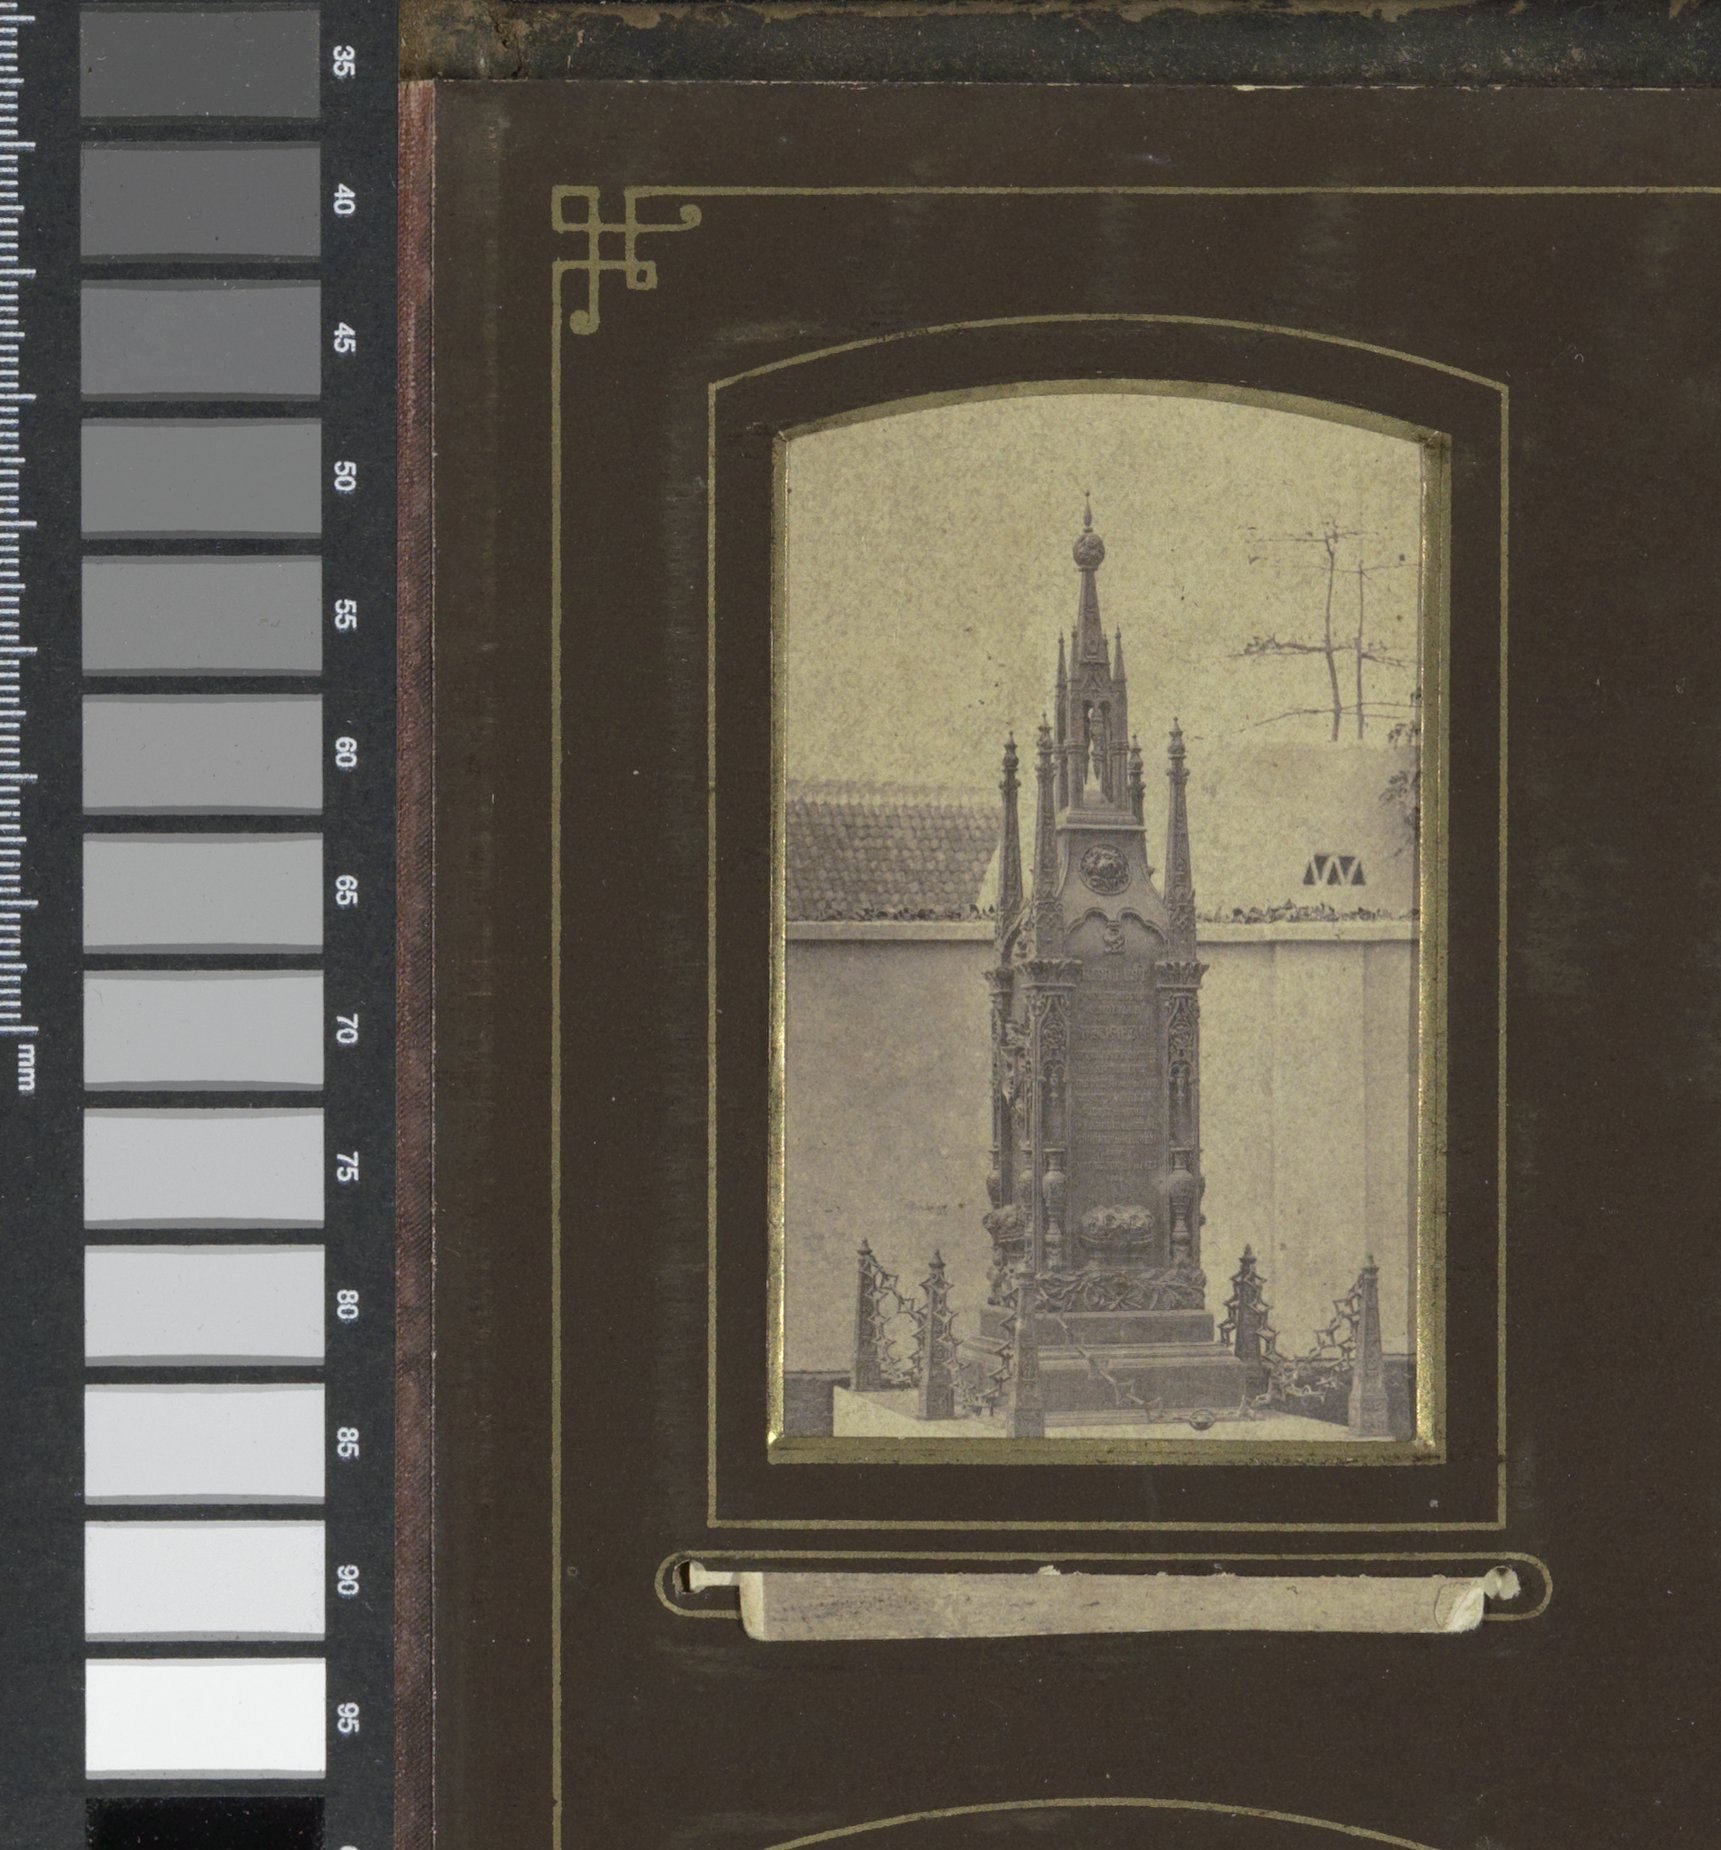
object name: photograph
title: Monument, vermoedelijk ter nagedachtenis van een omgekomen militair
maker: Anonymous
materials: paper, photographic support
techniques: albumen print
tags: monument, statue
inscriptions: inscription: ‘[...]ier rust Paul, François, Corneil[...] [...]reede Luit Kol der art Diveet [onz] va[...] [...]e art. Con[...] winkel. Ridder der[...] [...]de van Karel II[...] [...]an Spanje geboren den 16 mei 18[...] [...]verleden den 18 Mei 1861. Achterzijde Hulde van de officieren en va[...] beambten van den A.E.[...] aan nagedachtenis van hunnen hoogeachten en beminden Chef. op de [...] zijde Het wapen van den overleden’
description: Onderdeel van Fotoalbum van de families Matthes, Doorman en Van Thiel.